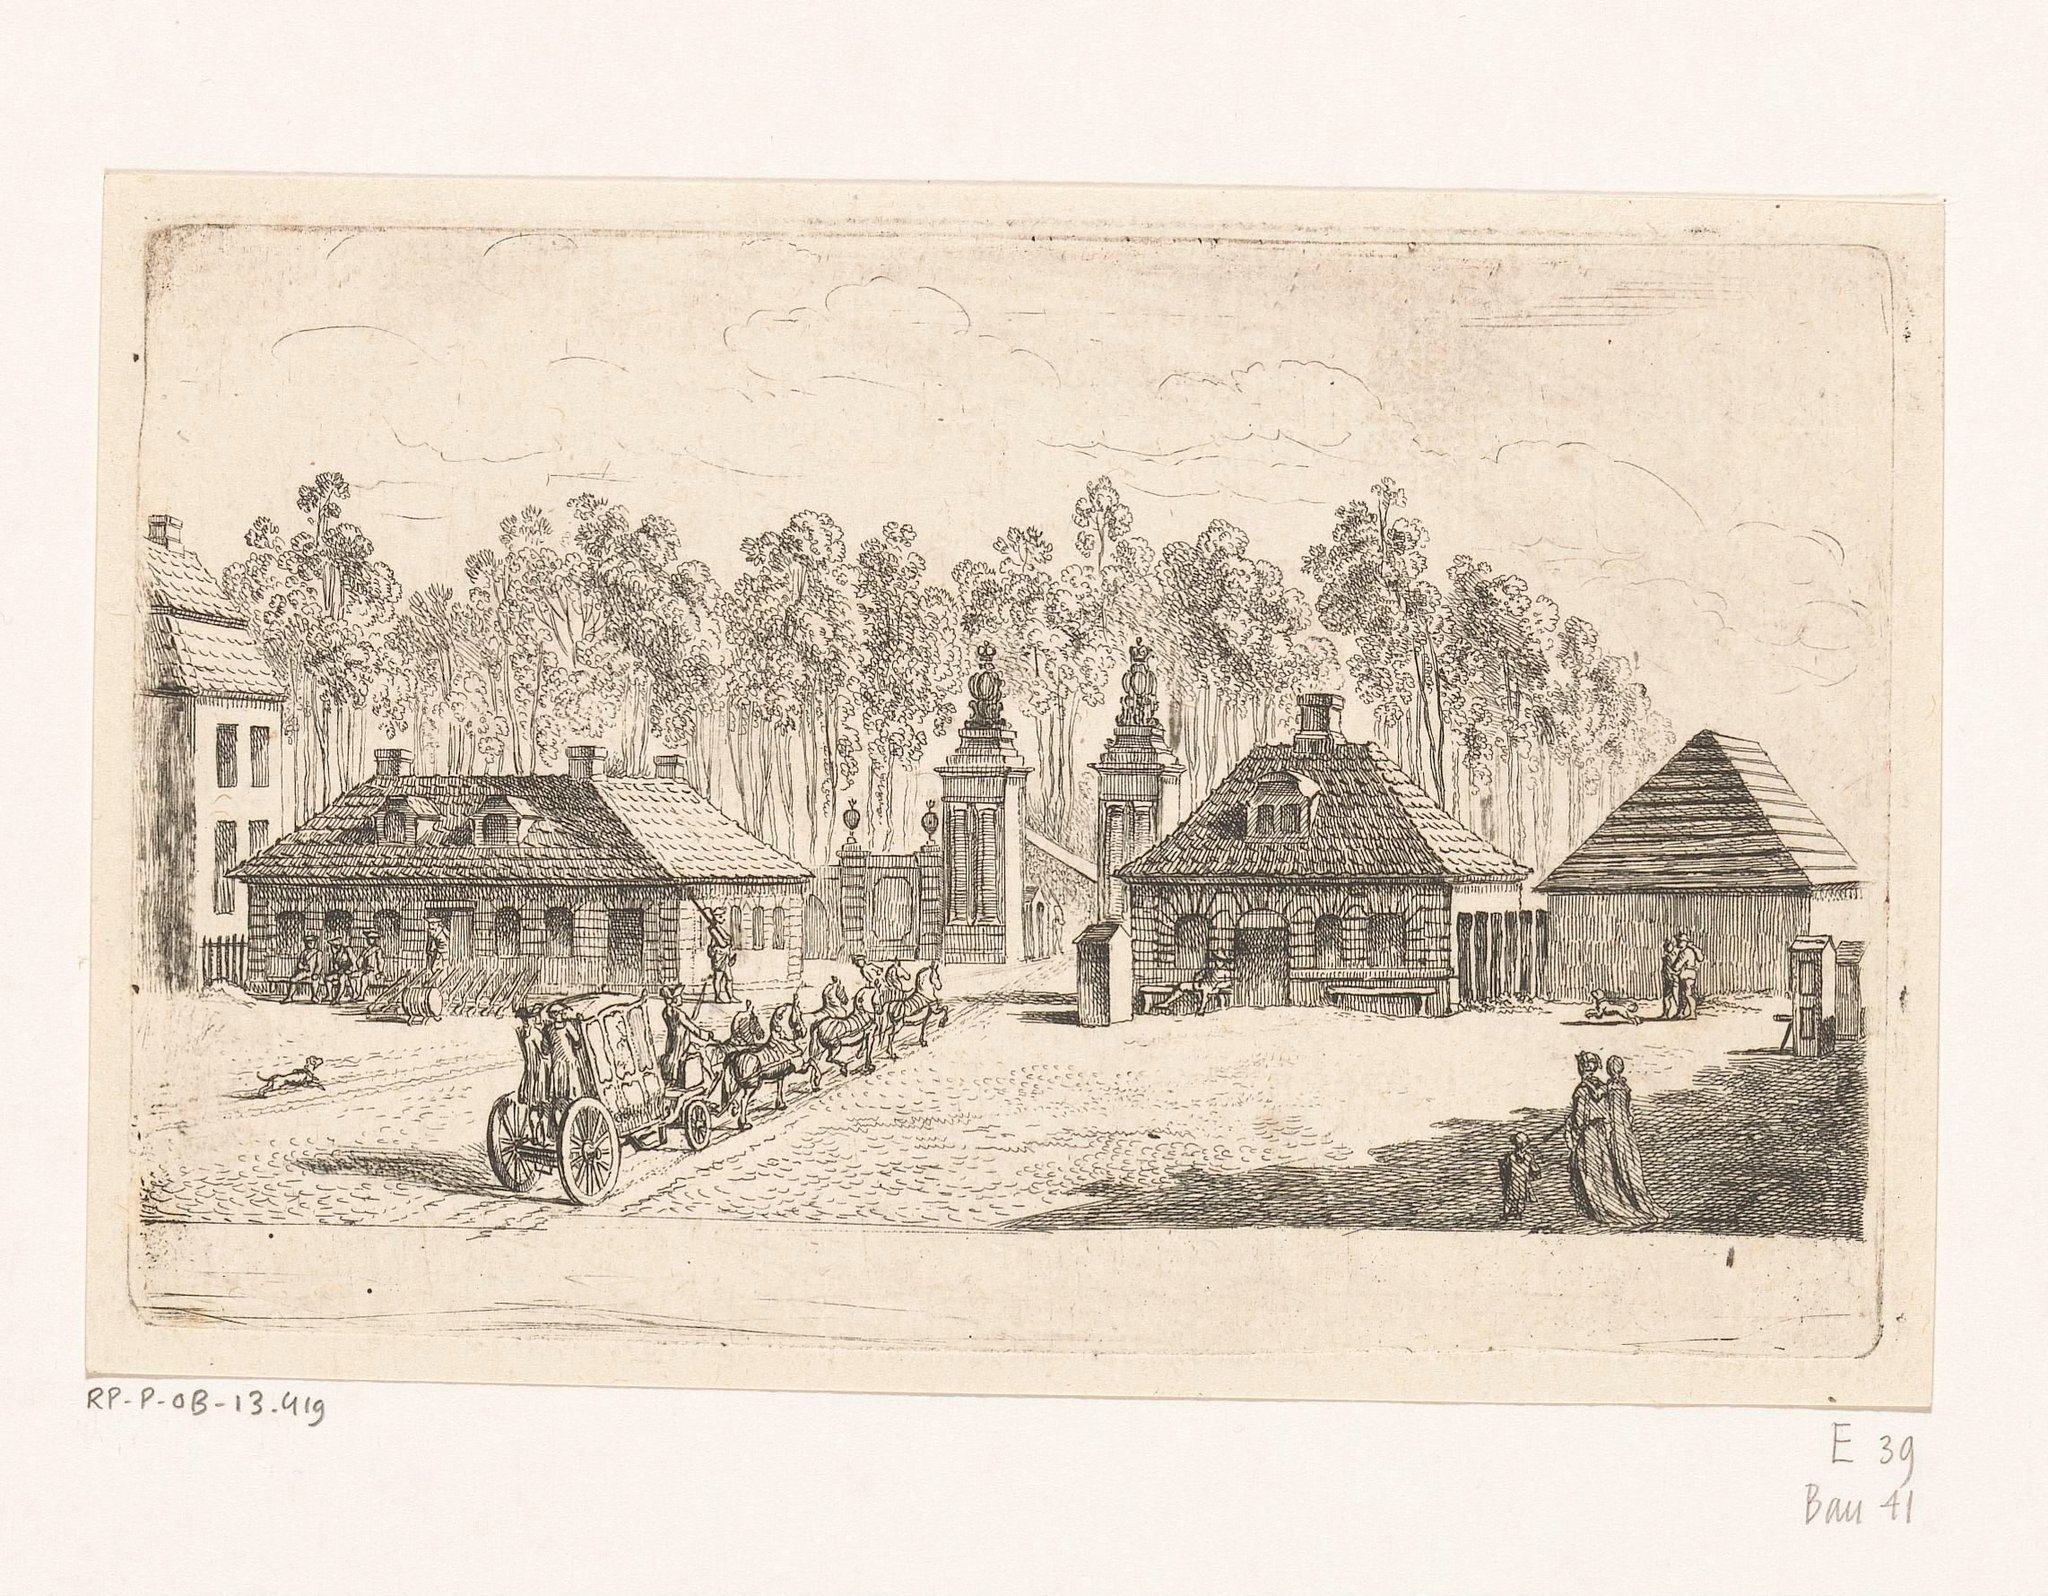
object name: print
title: Brandenburger Tor in Berlijn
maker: daniel nikolaus chodowiecki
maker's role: draughtsman, print maker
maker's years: 1726-1801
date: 1764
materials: paper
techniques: etching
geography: berlin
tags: four-wheeled vehicle drawn by more than three animals, city-gate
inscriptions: collector's mark: Lugt 2228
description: De Brandenburger Tor werd in 1736 opgericht onder koning Friedrich Wilhelm I en in 1789 onder koning Friedrich Wilhelm II vervangen door de huidige Brandenburger Tor. Deze ets van Chodowiecki is een van de weinige afbeeldingen van de oude Brandenburger Tor.